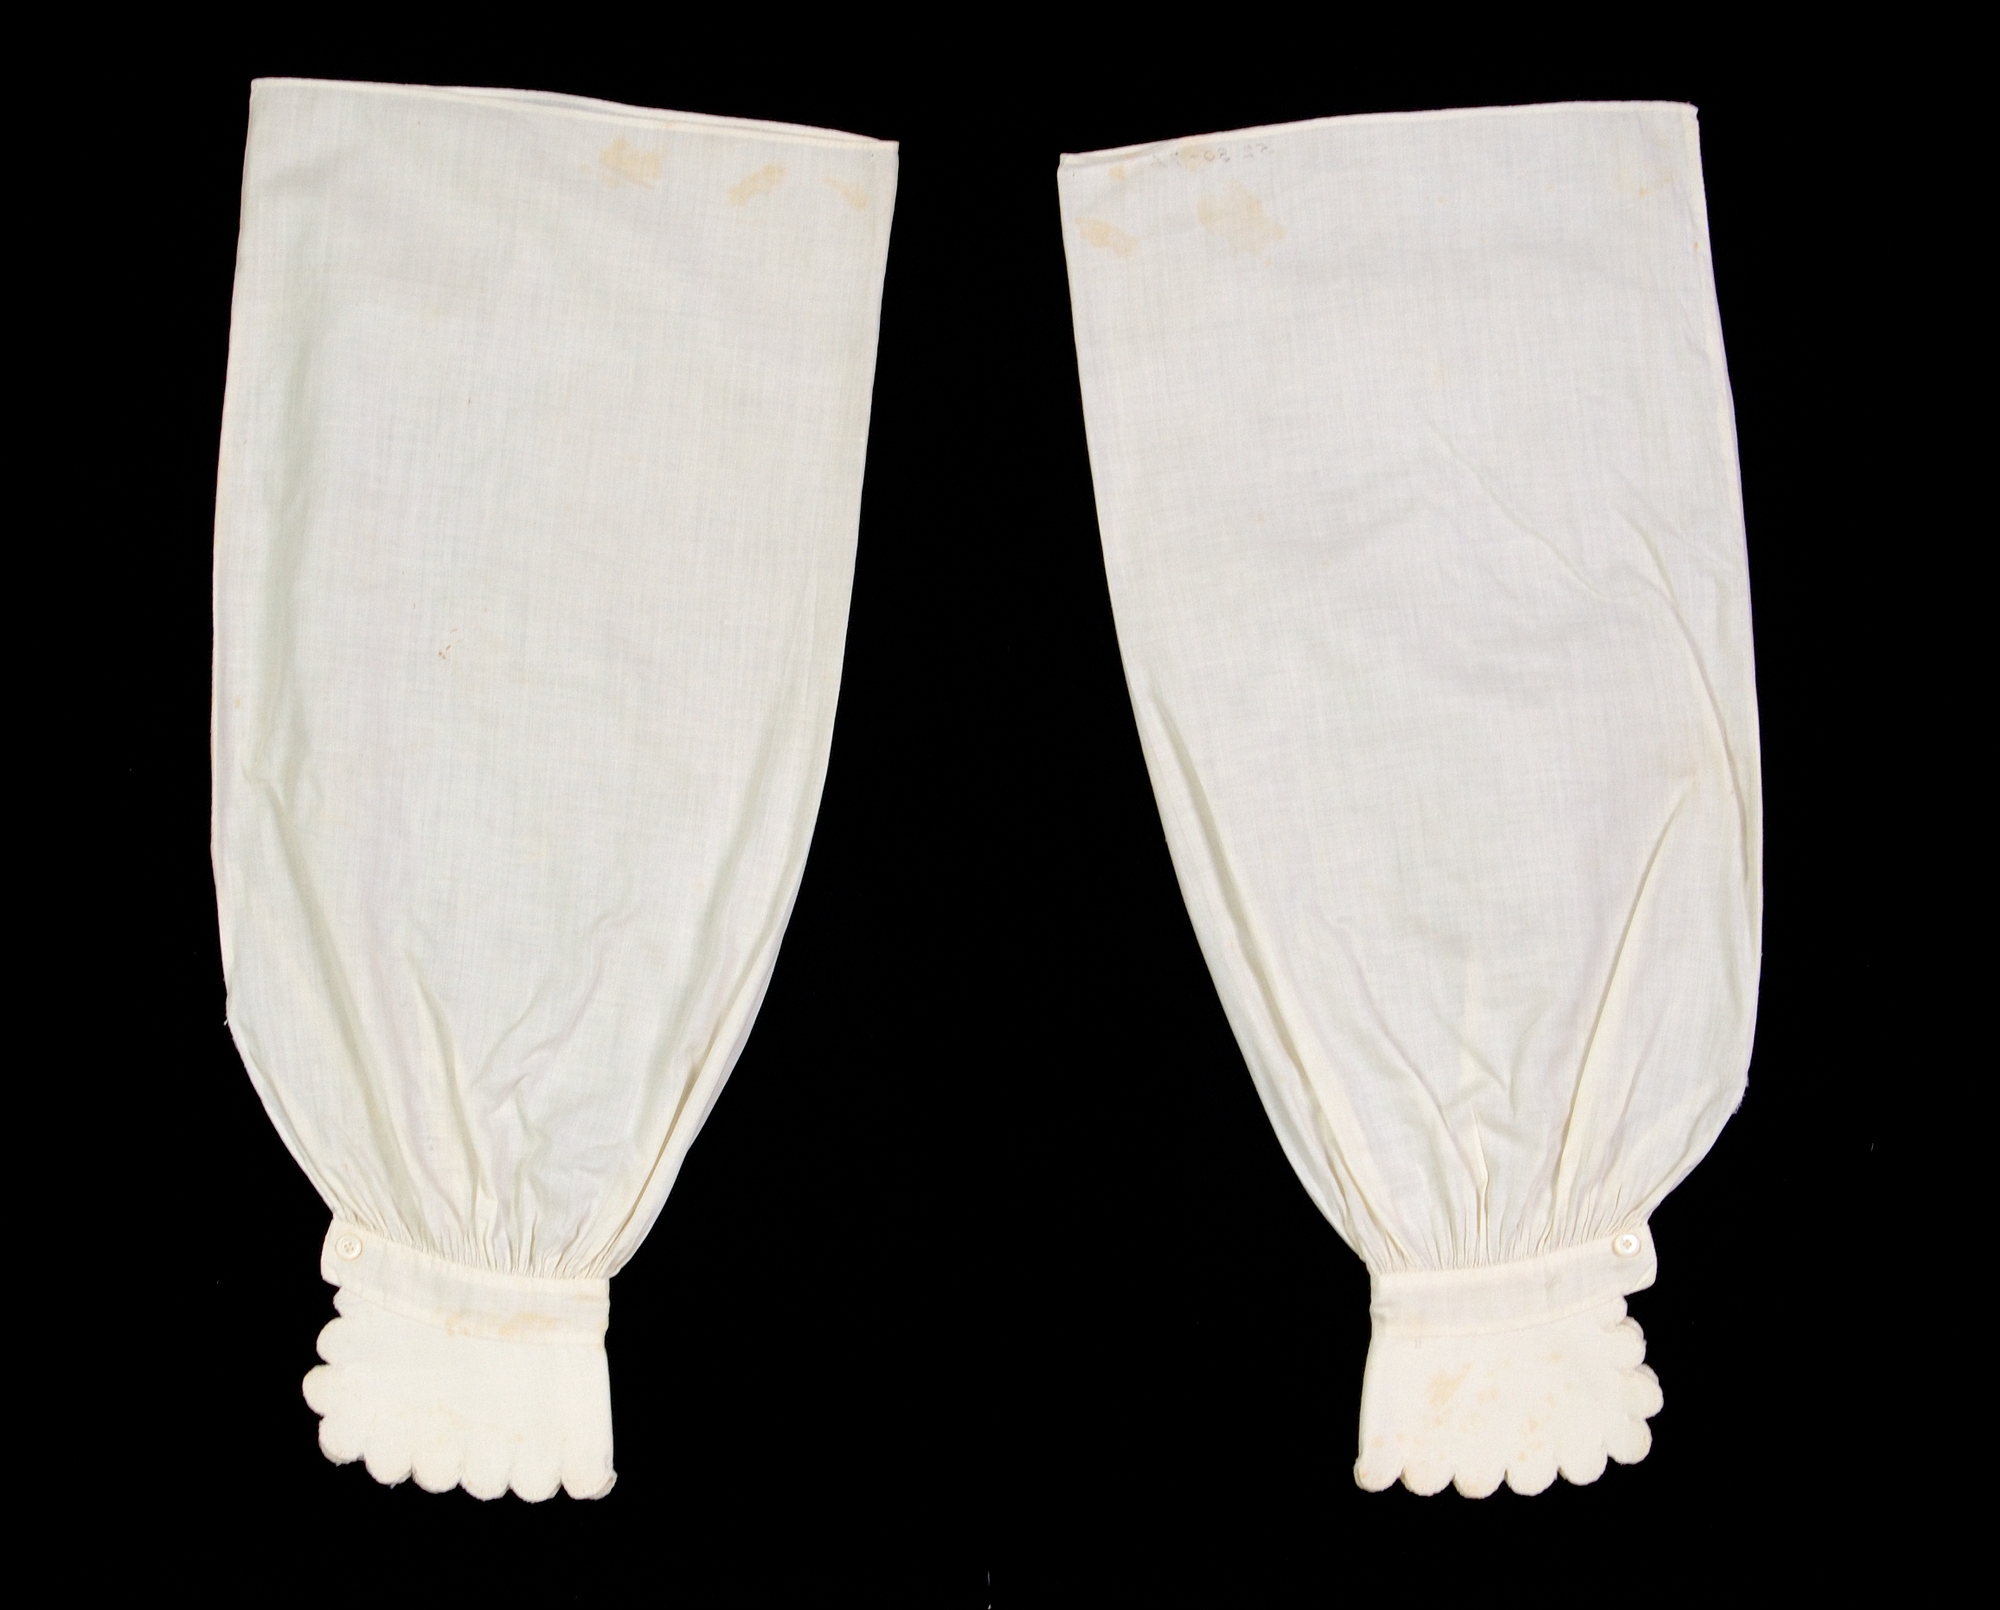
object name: undersleeves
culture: american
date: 1860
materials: cotton